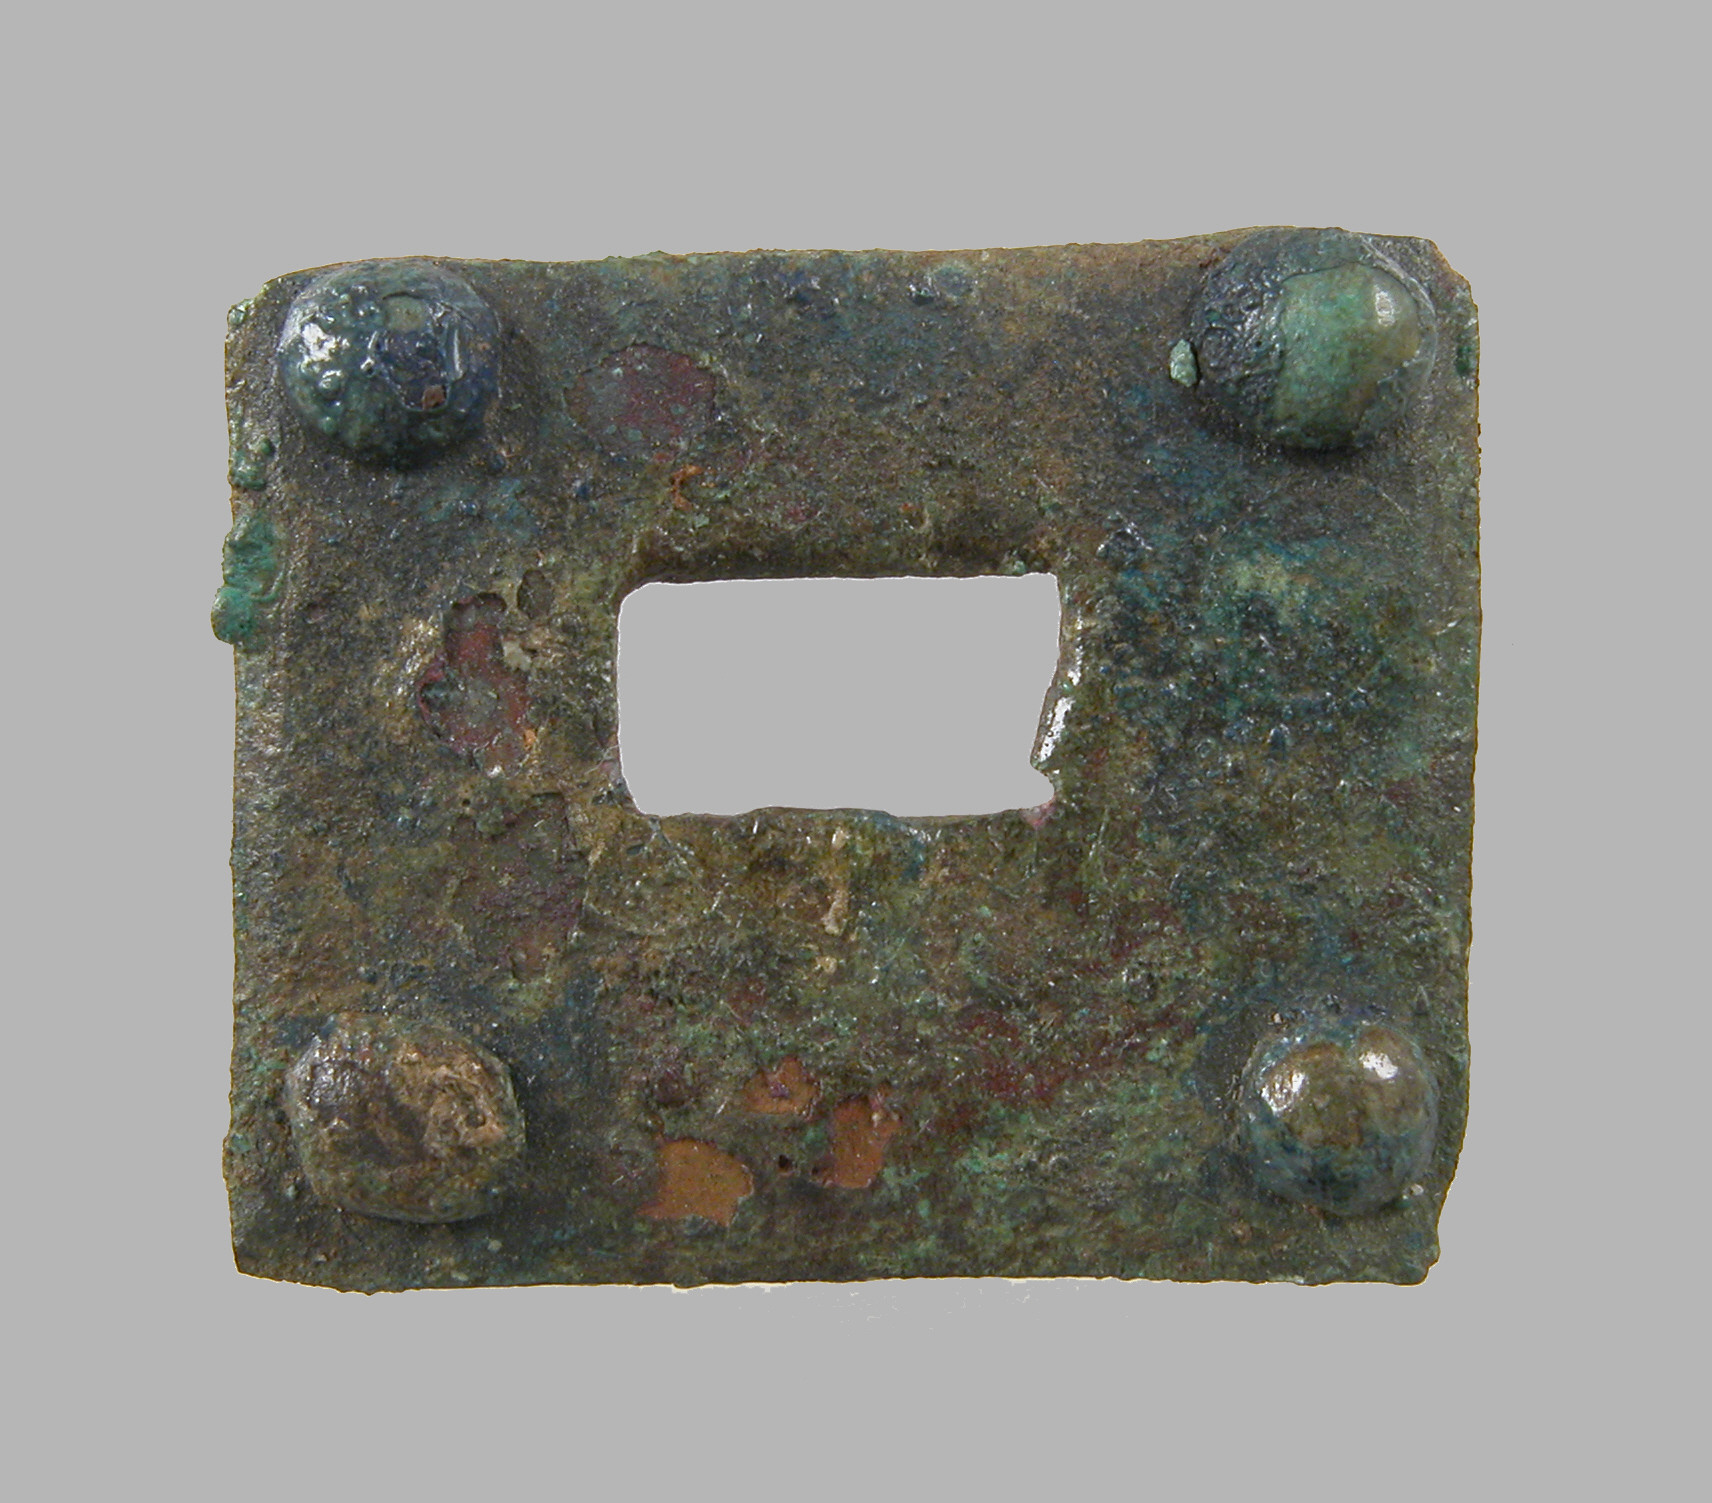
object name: plaque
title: Rectangular Plaque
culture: frankish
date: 534-566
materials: copper alloy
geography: germany